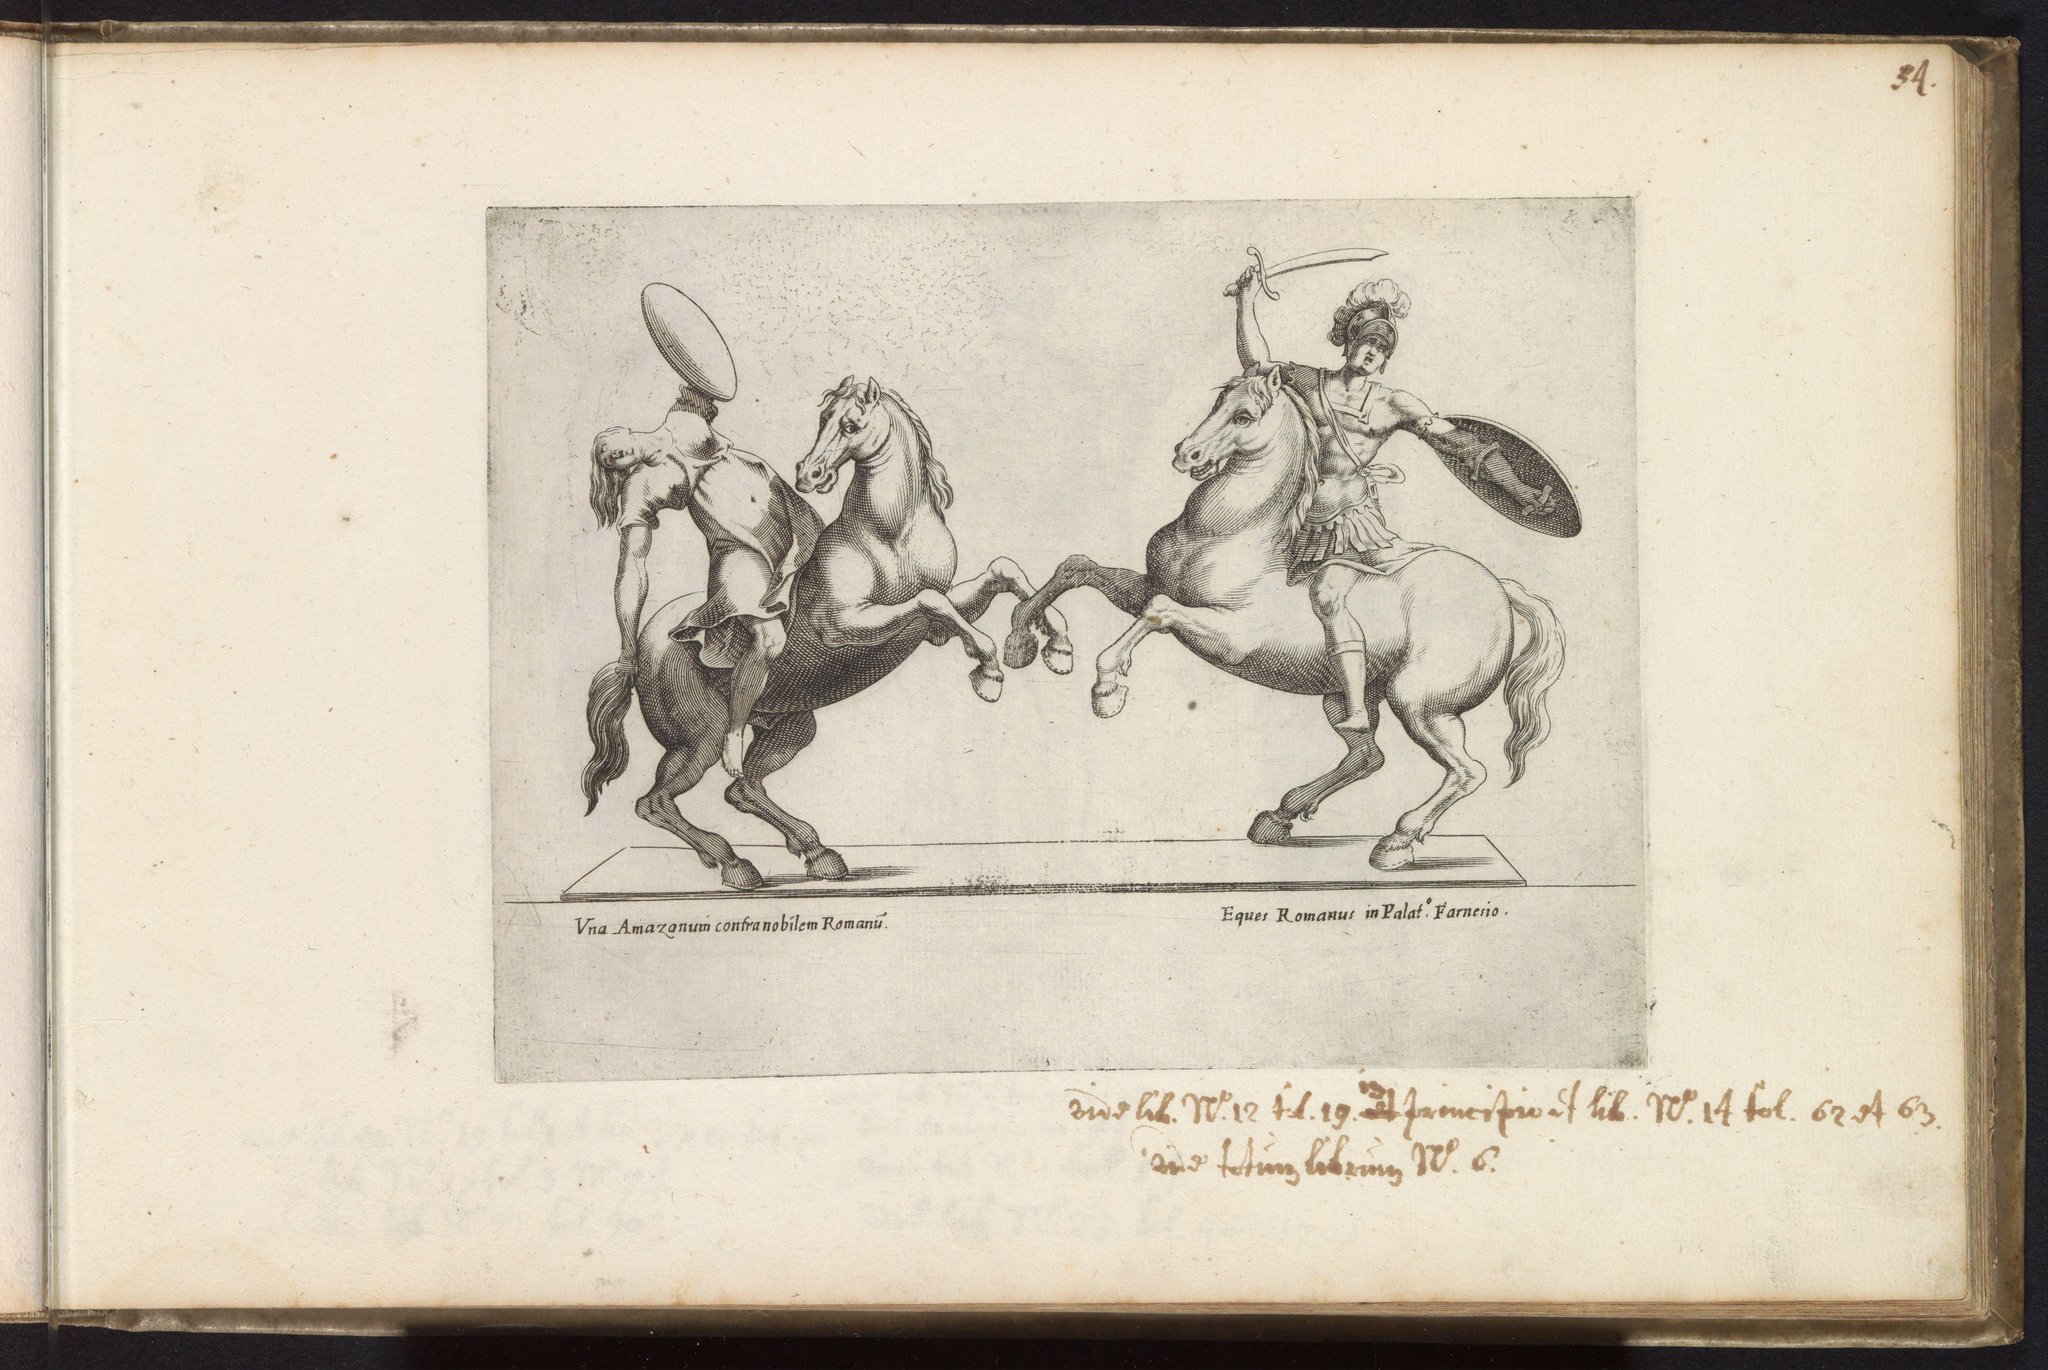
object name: album leaf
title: Sculpturen van een Amazone te paard en een Romeinse soldaat te paard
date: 1538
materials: paper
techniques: engraving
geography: vatican city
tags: (story of) the amazons, piece of sculpture, reproduction of a piece of sculpture, the soldier; the soldier's life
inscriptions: number: ‘54’, inscription: ‘Ende lib. No. 12 fol. 19 [...] lib. No. 14 fol. 62 et 63./ Ende [...] No. 6.’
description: Deze prent maakt deel uit van een reeks van ten minste 19 prenten van sculpturen uit de oudheid. De beelden bevinden zich in het Museo archeologico Nazionale di Napoli.